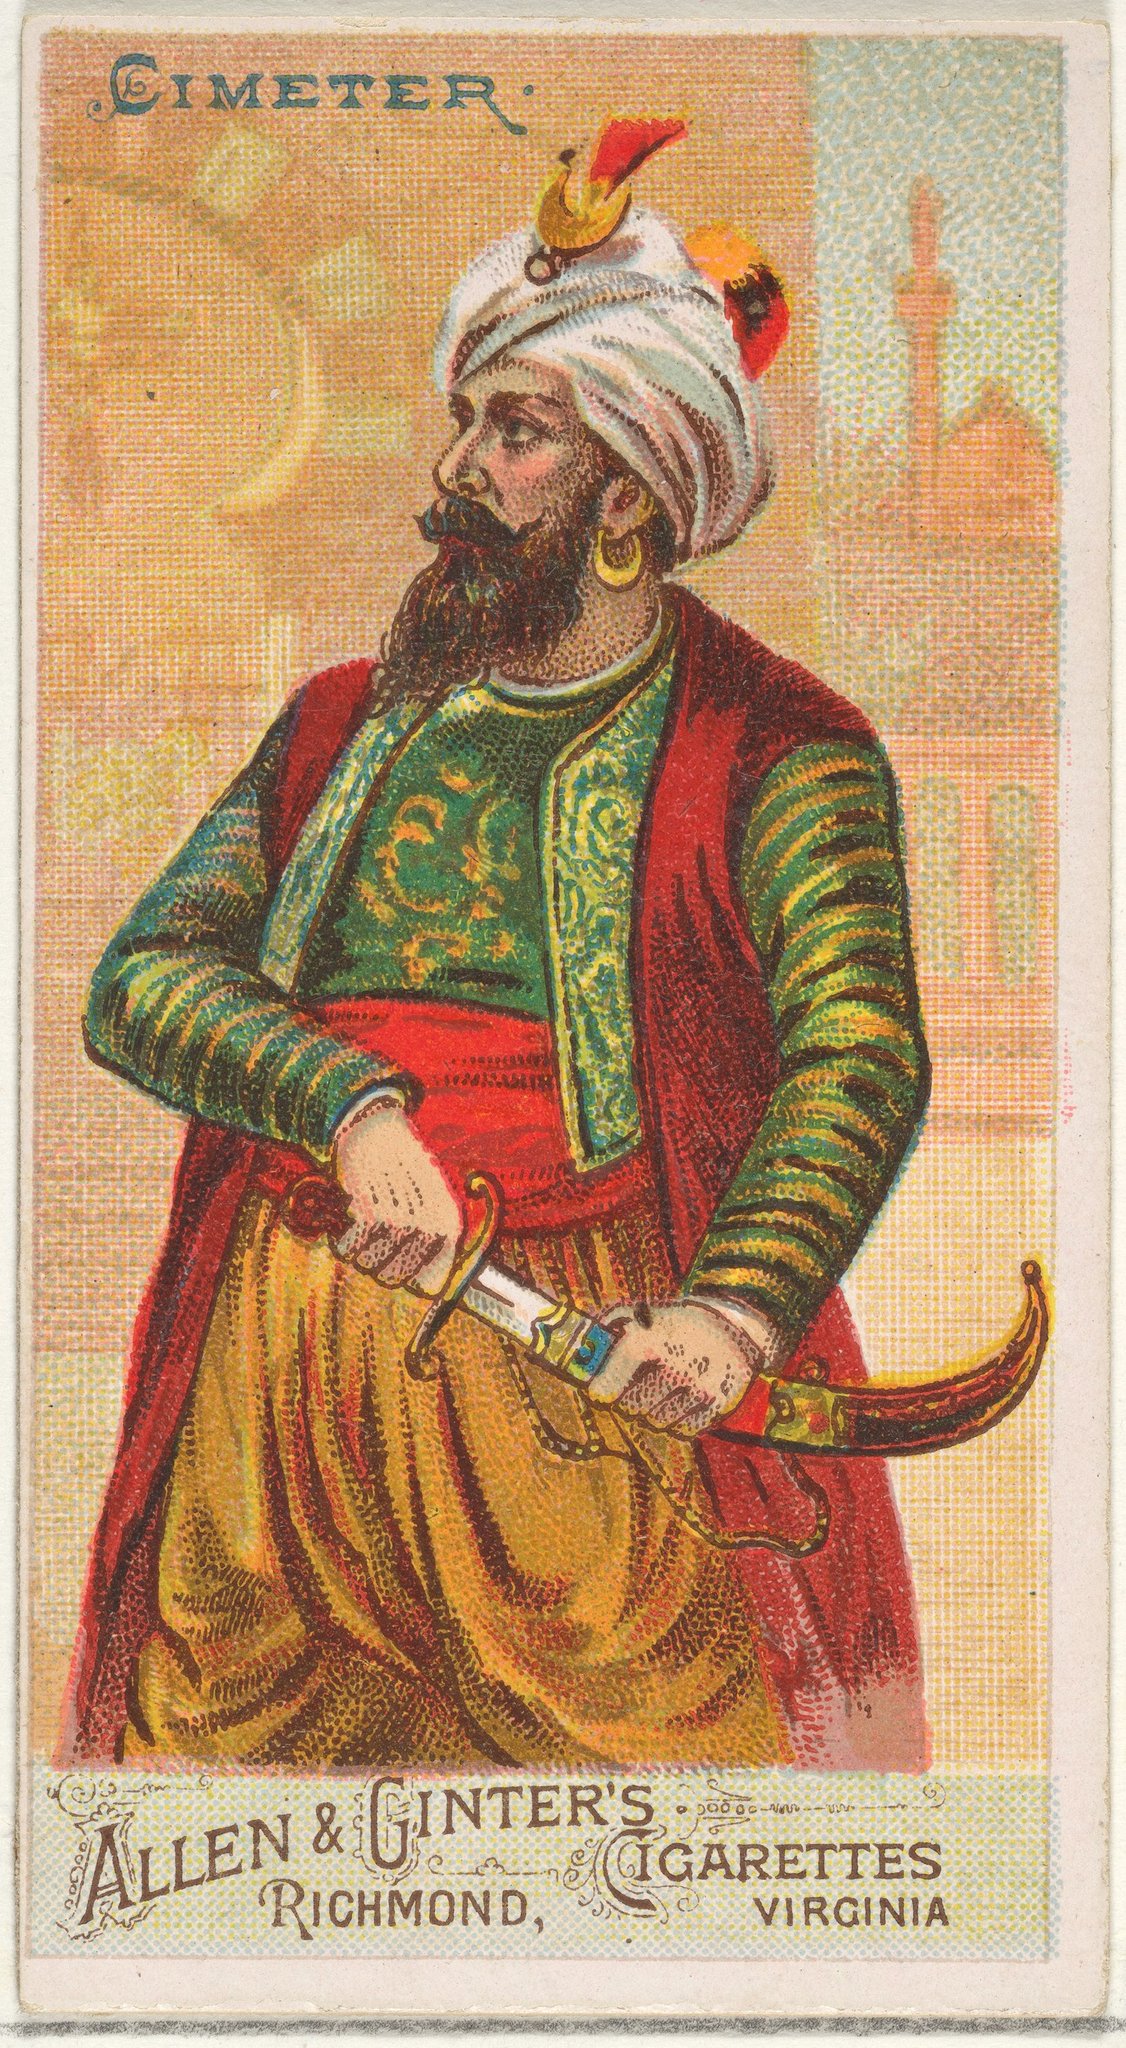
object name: print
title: Cimeter, from the Arms of All Nations series (N3) for Allen & Ginter Cigarettes Brands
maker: allen & ginter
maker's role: publisher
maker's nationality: american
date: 1887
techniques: color lithograph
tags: knives,men